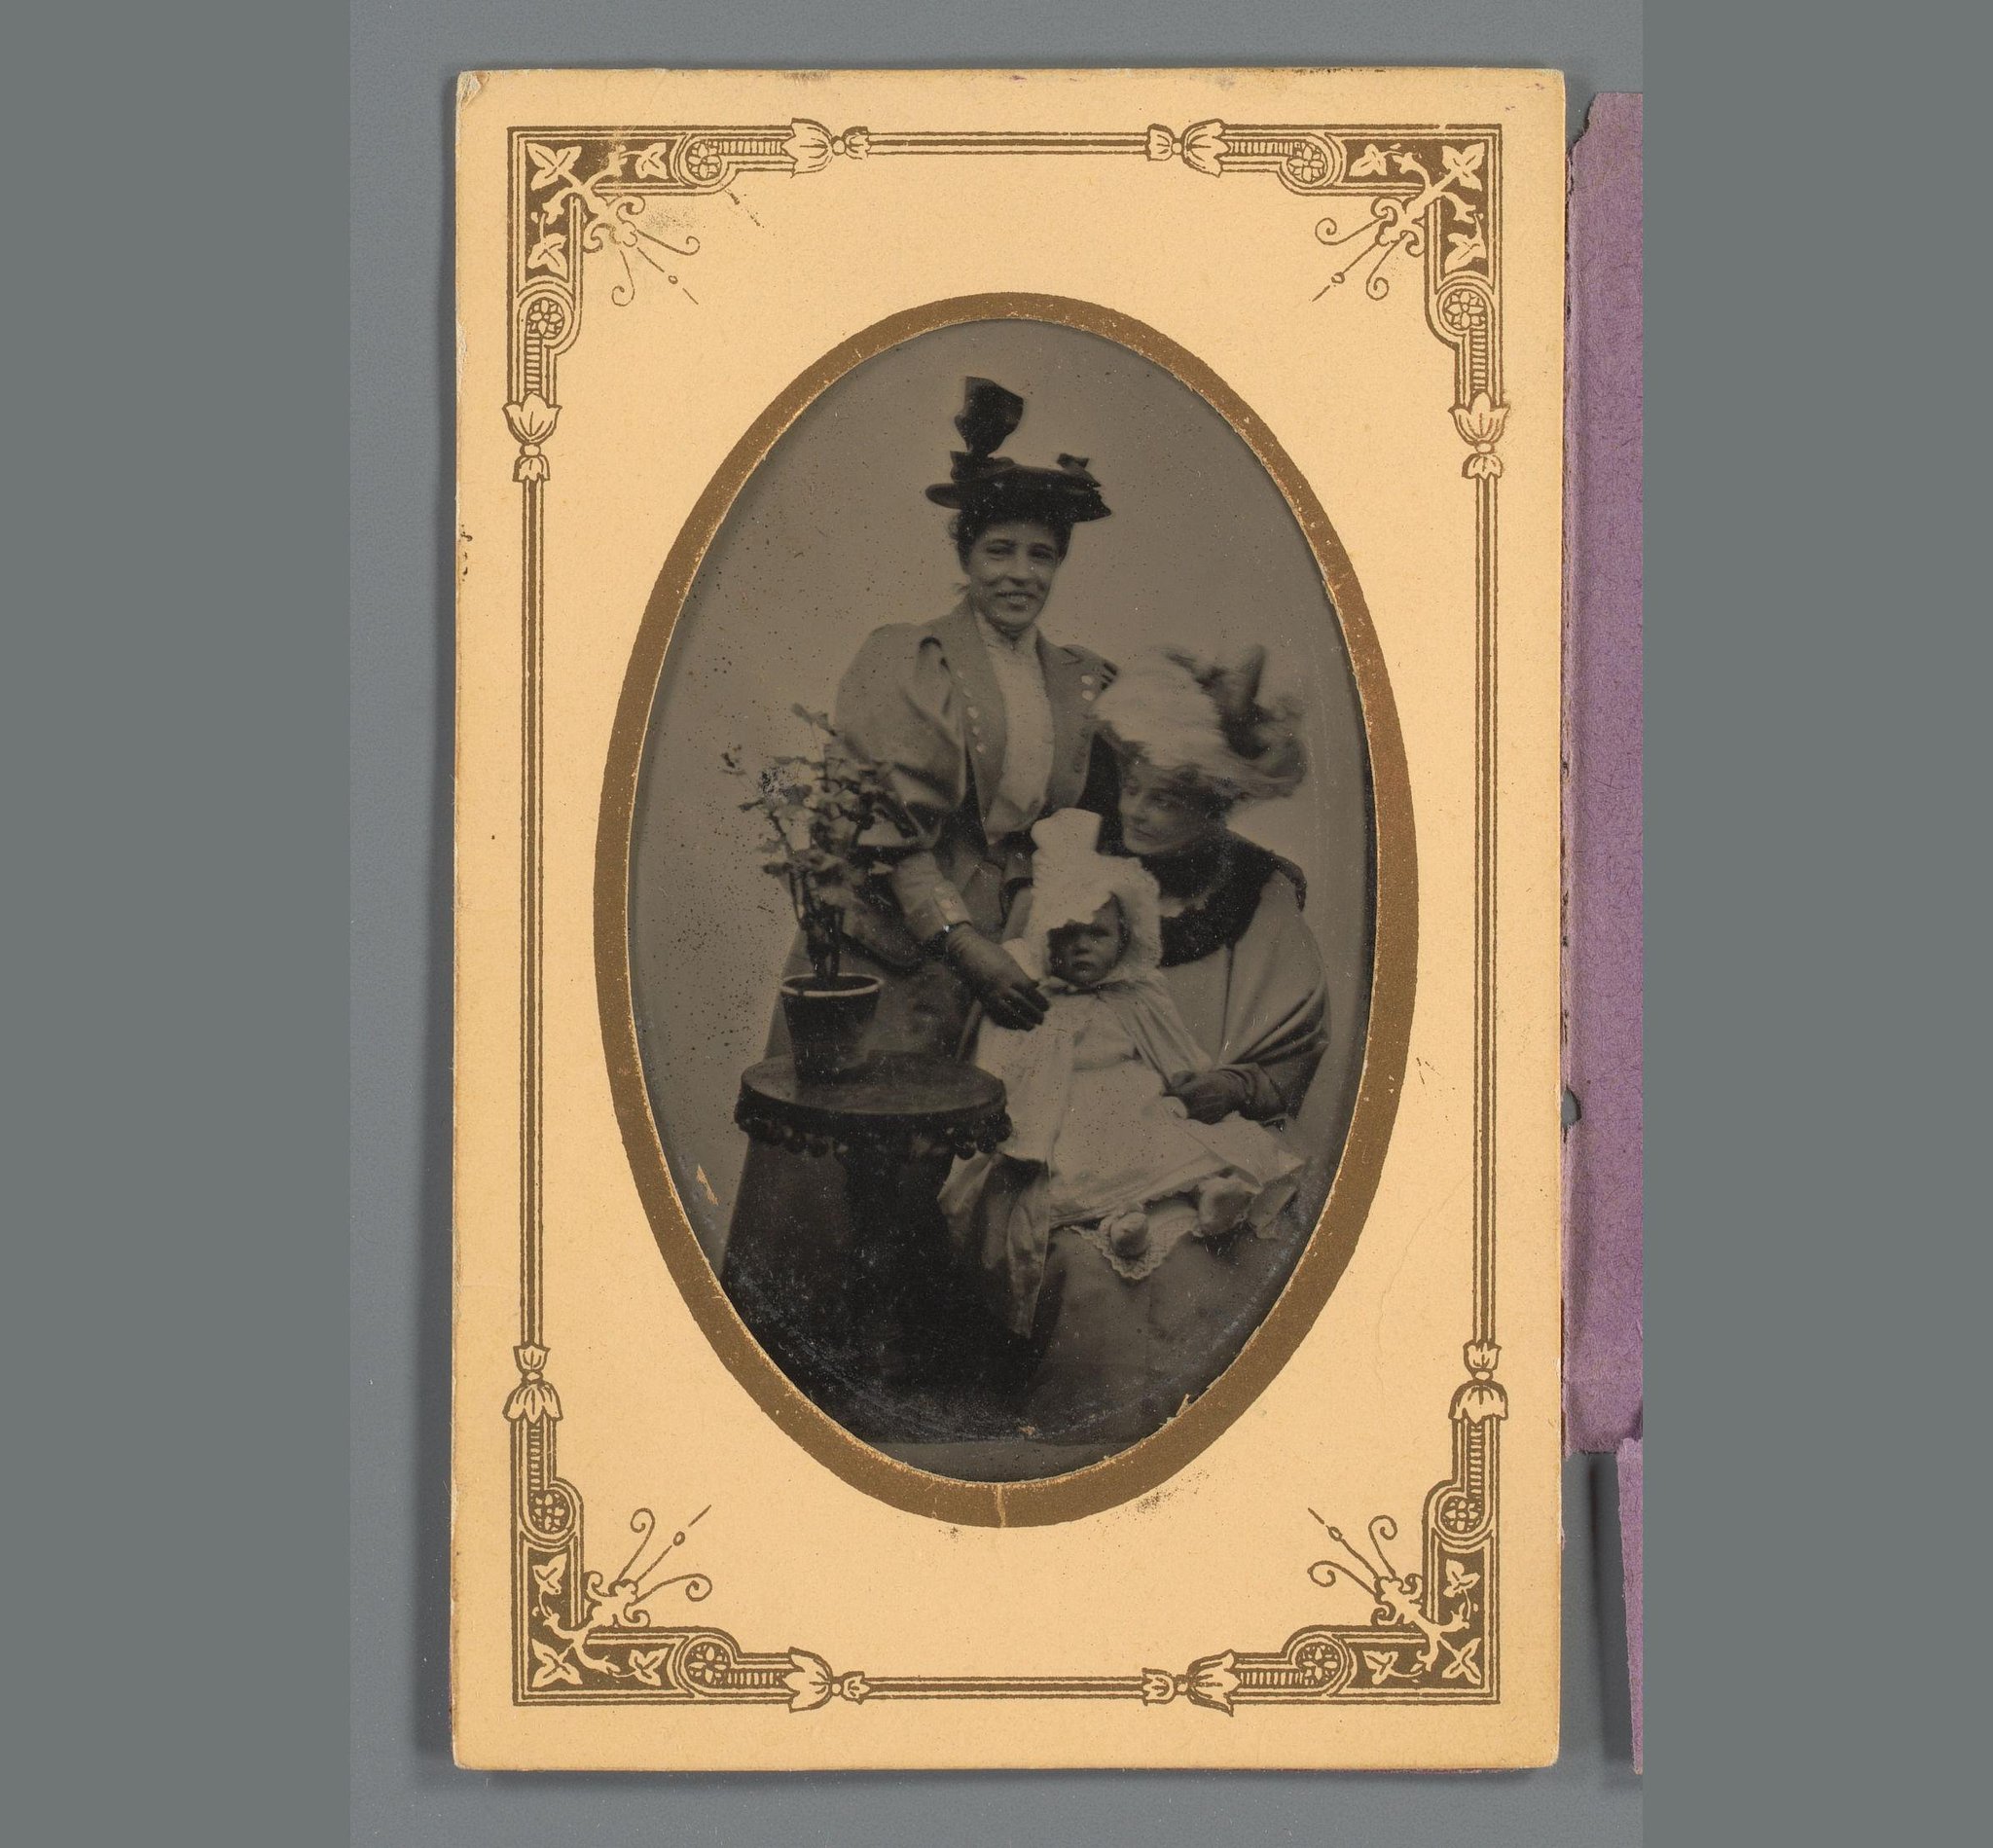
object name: photograph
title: Groepsportret van Gerarda (Ida) van Tonderen met dochter Johanna (Hans) de Jong en zus Elisabeth van Tonderen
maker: Anonymous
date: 1896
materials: cardboard, iron, paper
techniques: ferrotyping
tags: elisabeth de jong-van tonderen, haarlem, leiden, johanna petronella lambertina stokhuyzen-de jong (hans), historical persons - bb - woman, mother and daughter(s) (family group)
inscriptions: date: ‘25 Juli 1896’, date: ‘25 Juli 96’